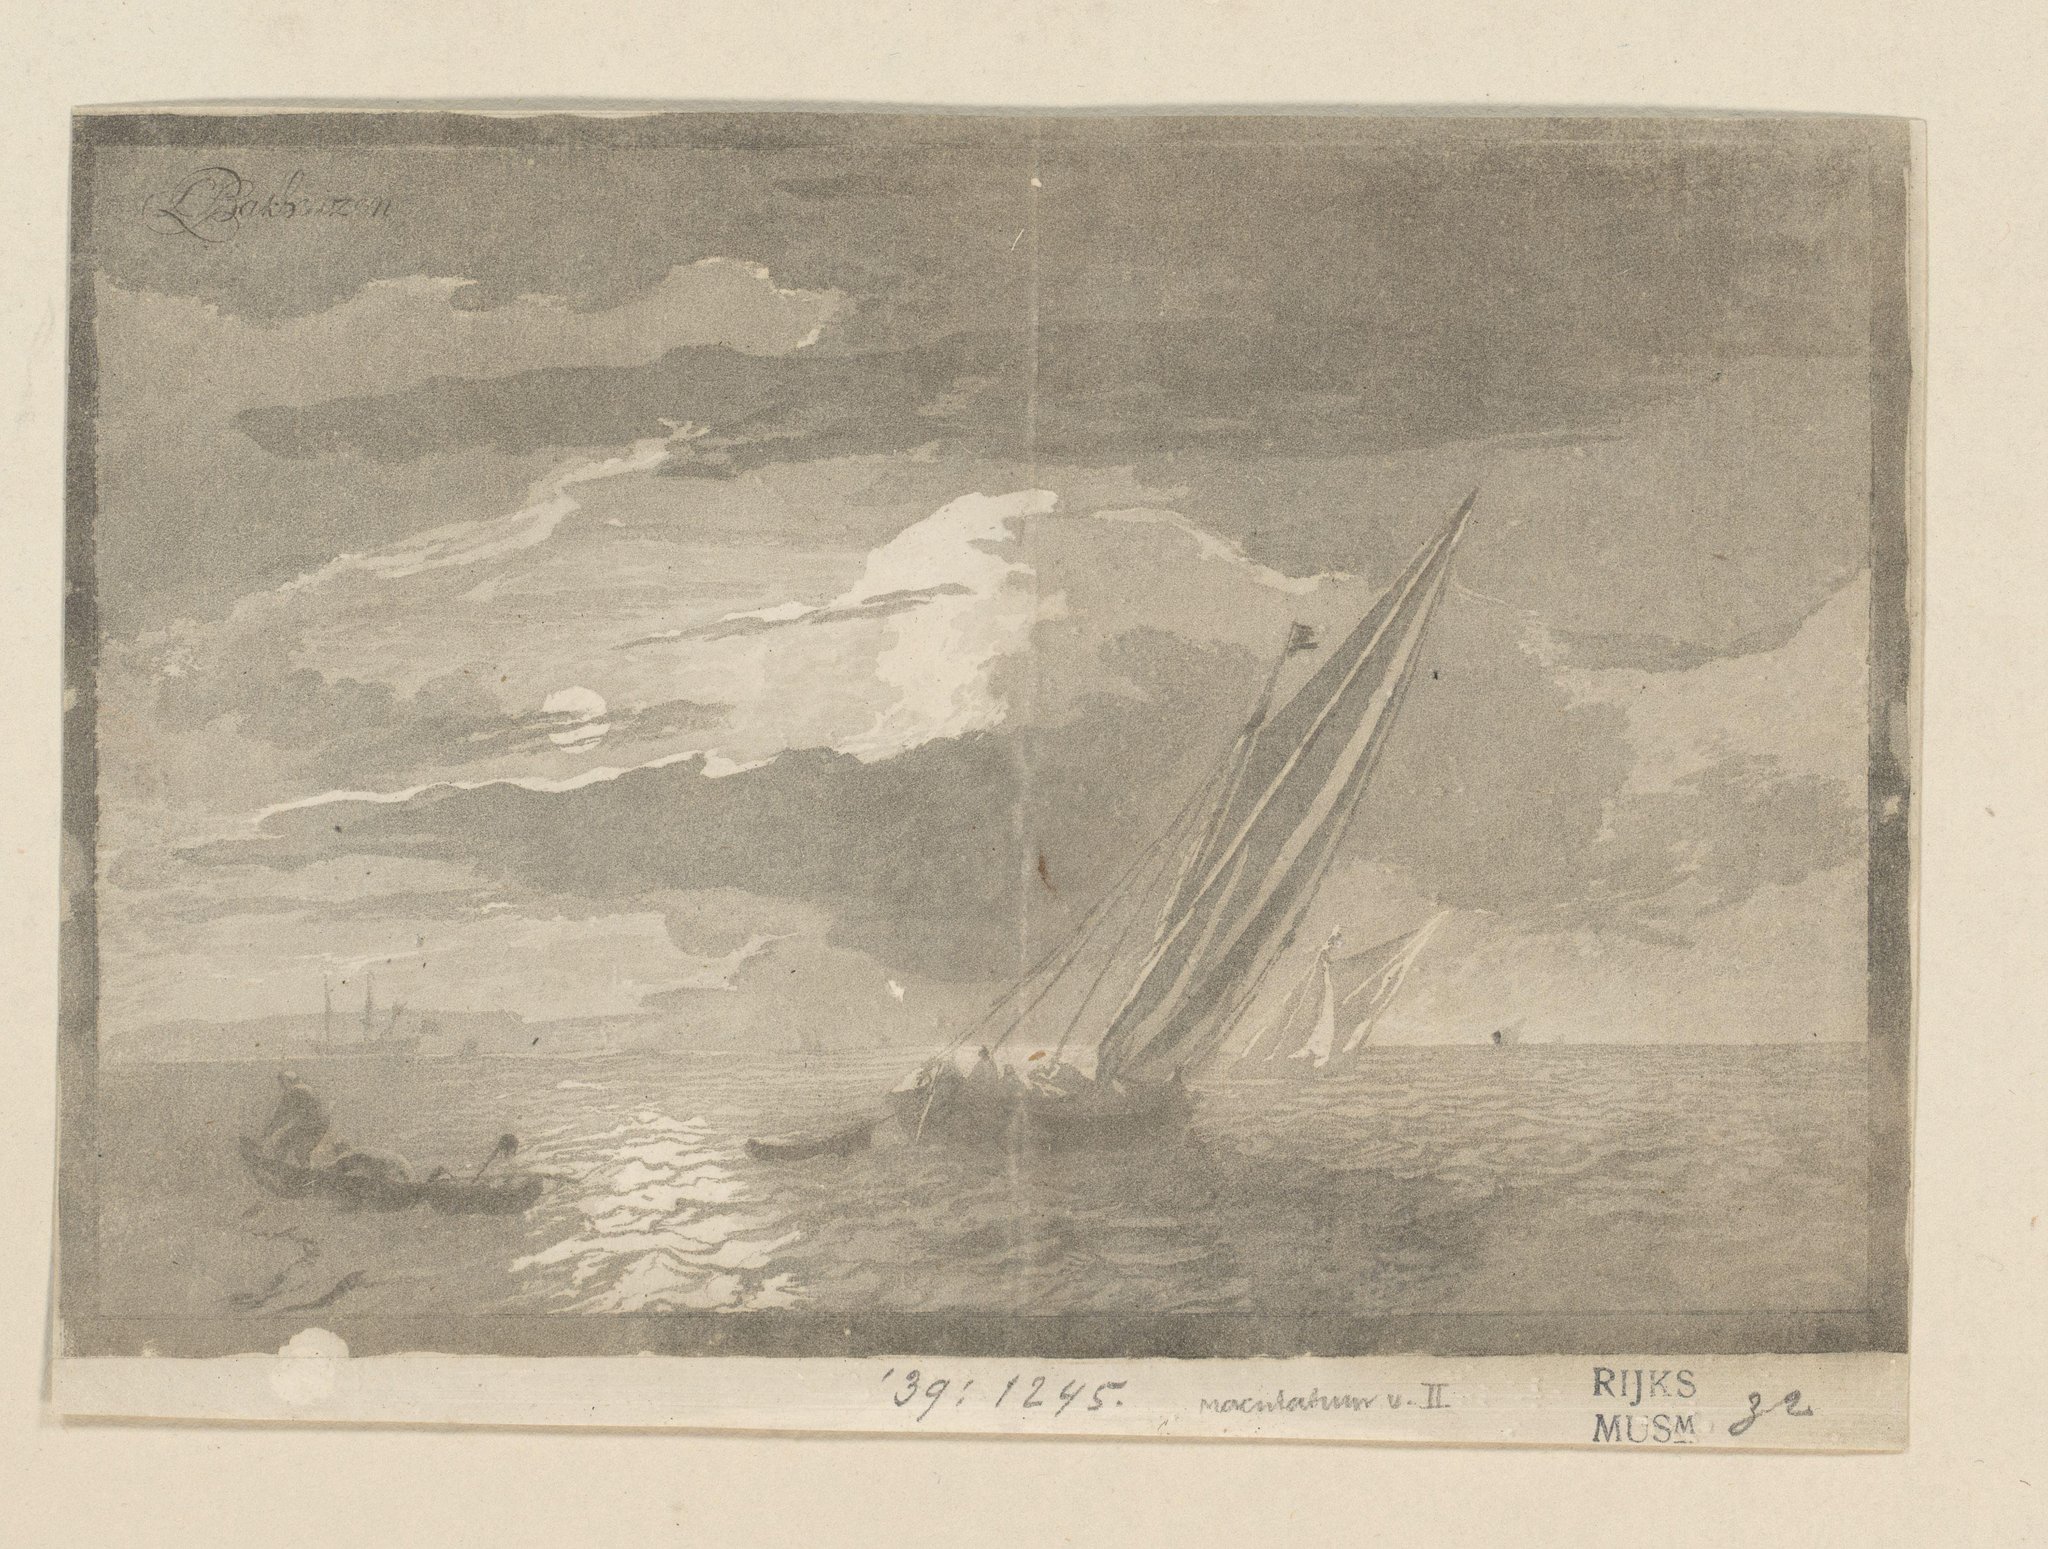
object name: maculature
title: Zeegezicht met volle maan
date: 1779-1781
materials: paper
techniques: transfer, print drawing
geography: amsterdam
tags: sailing-ship, sailing-boat, moonlight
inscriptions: collector's mark: ‘RIJKS / MUSM’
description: Op zee varen twee zeilschepen. Een visser haalt vanuit een sloep zijn netten binnen. De prent ligt los in een album, zie blad 33.